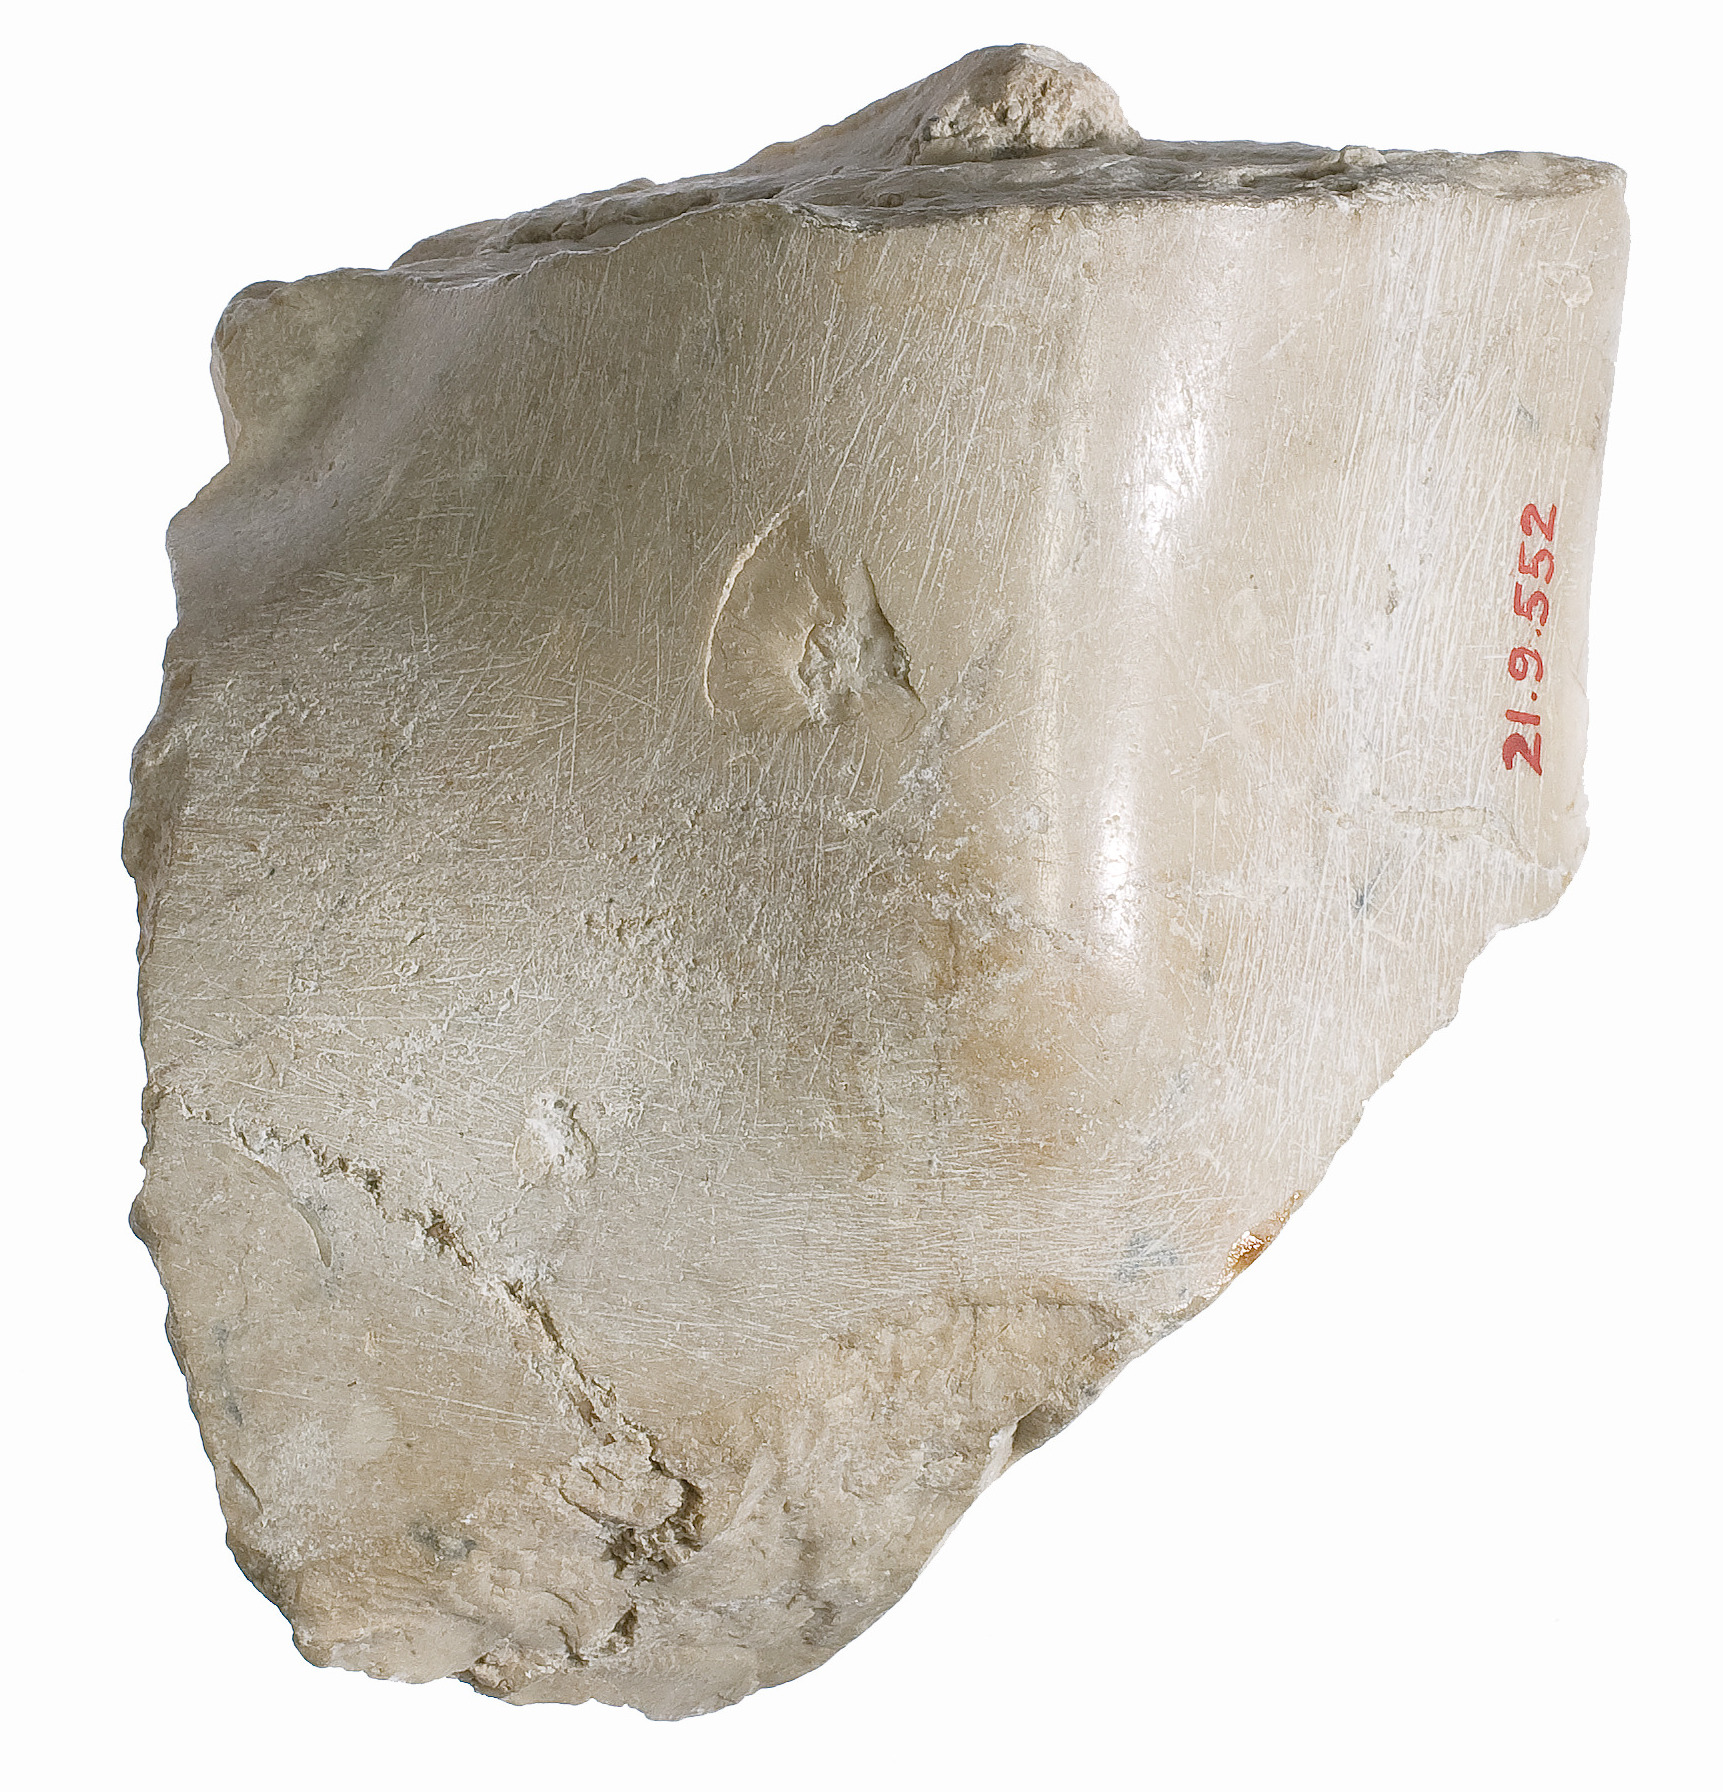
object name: foot fragment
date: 1353-1336 BCE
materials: limestone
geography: egypt